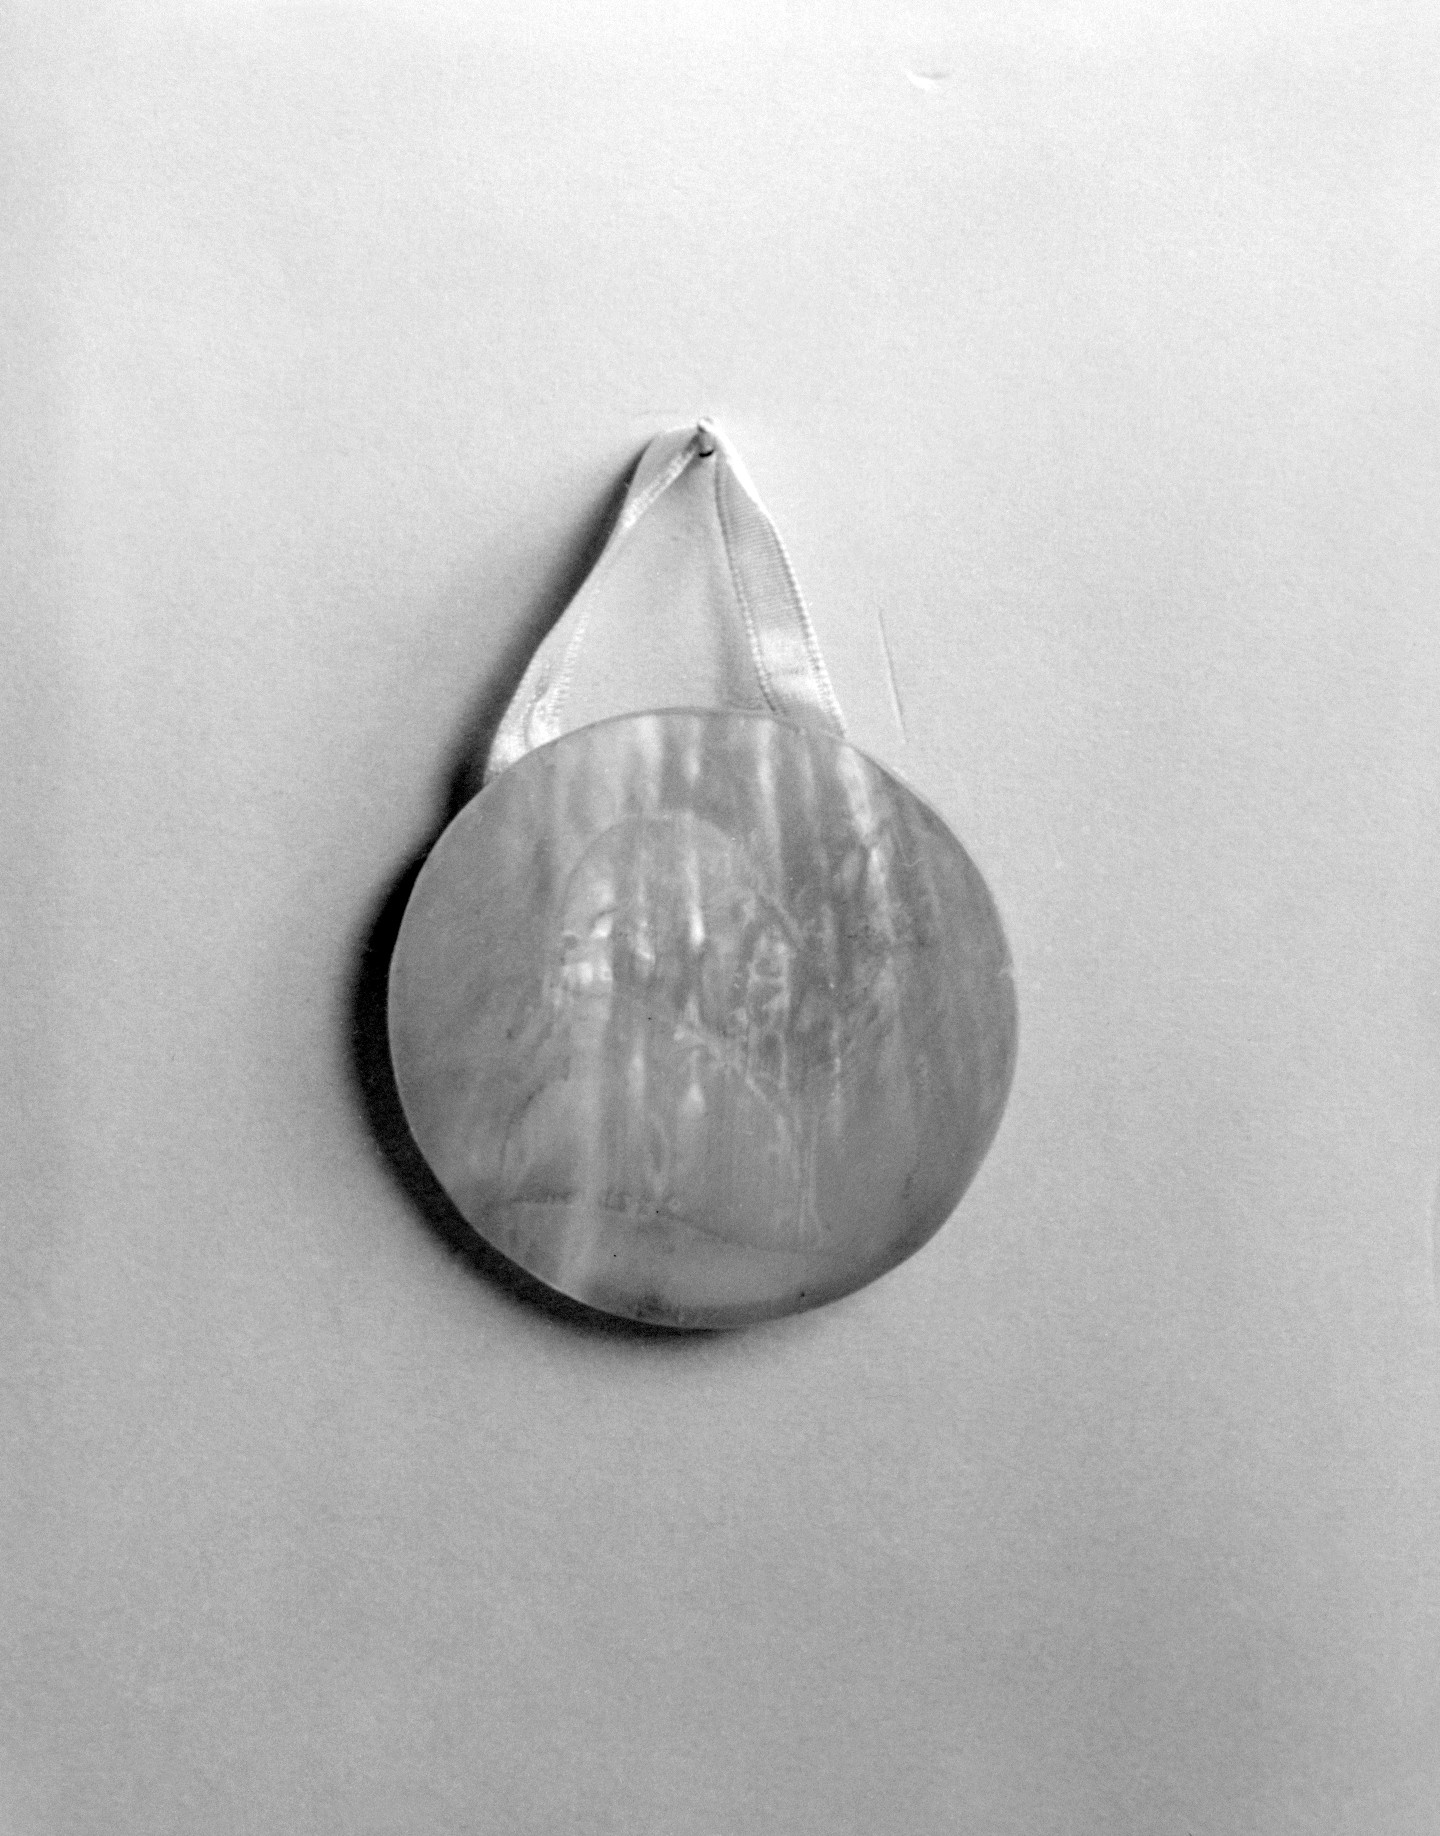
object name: medallion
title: Portrait of an officer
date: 1701-1900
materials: mother of pearl, ribbon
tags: men,profiles